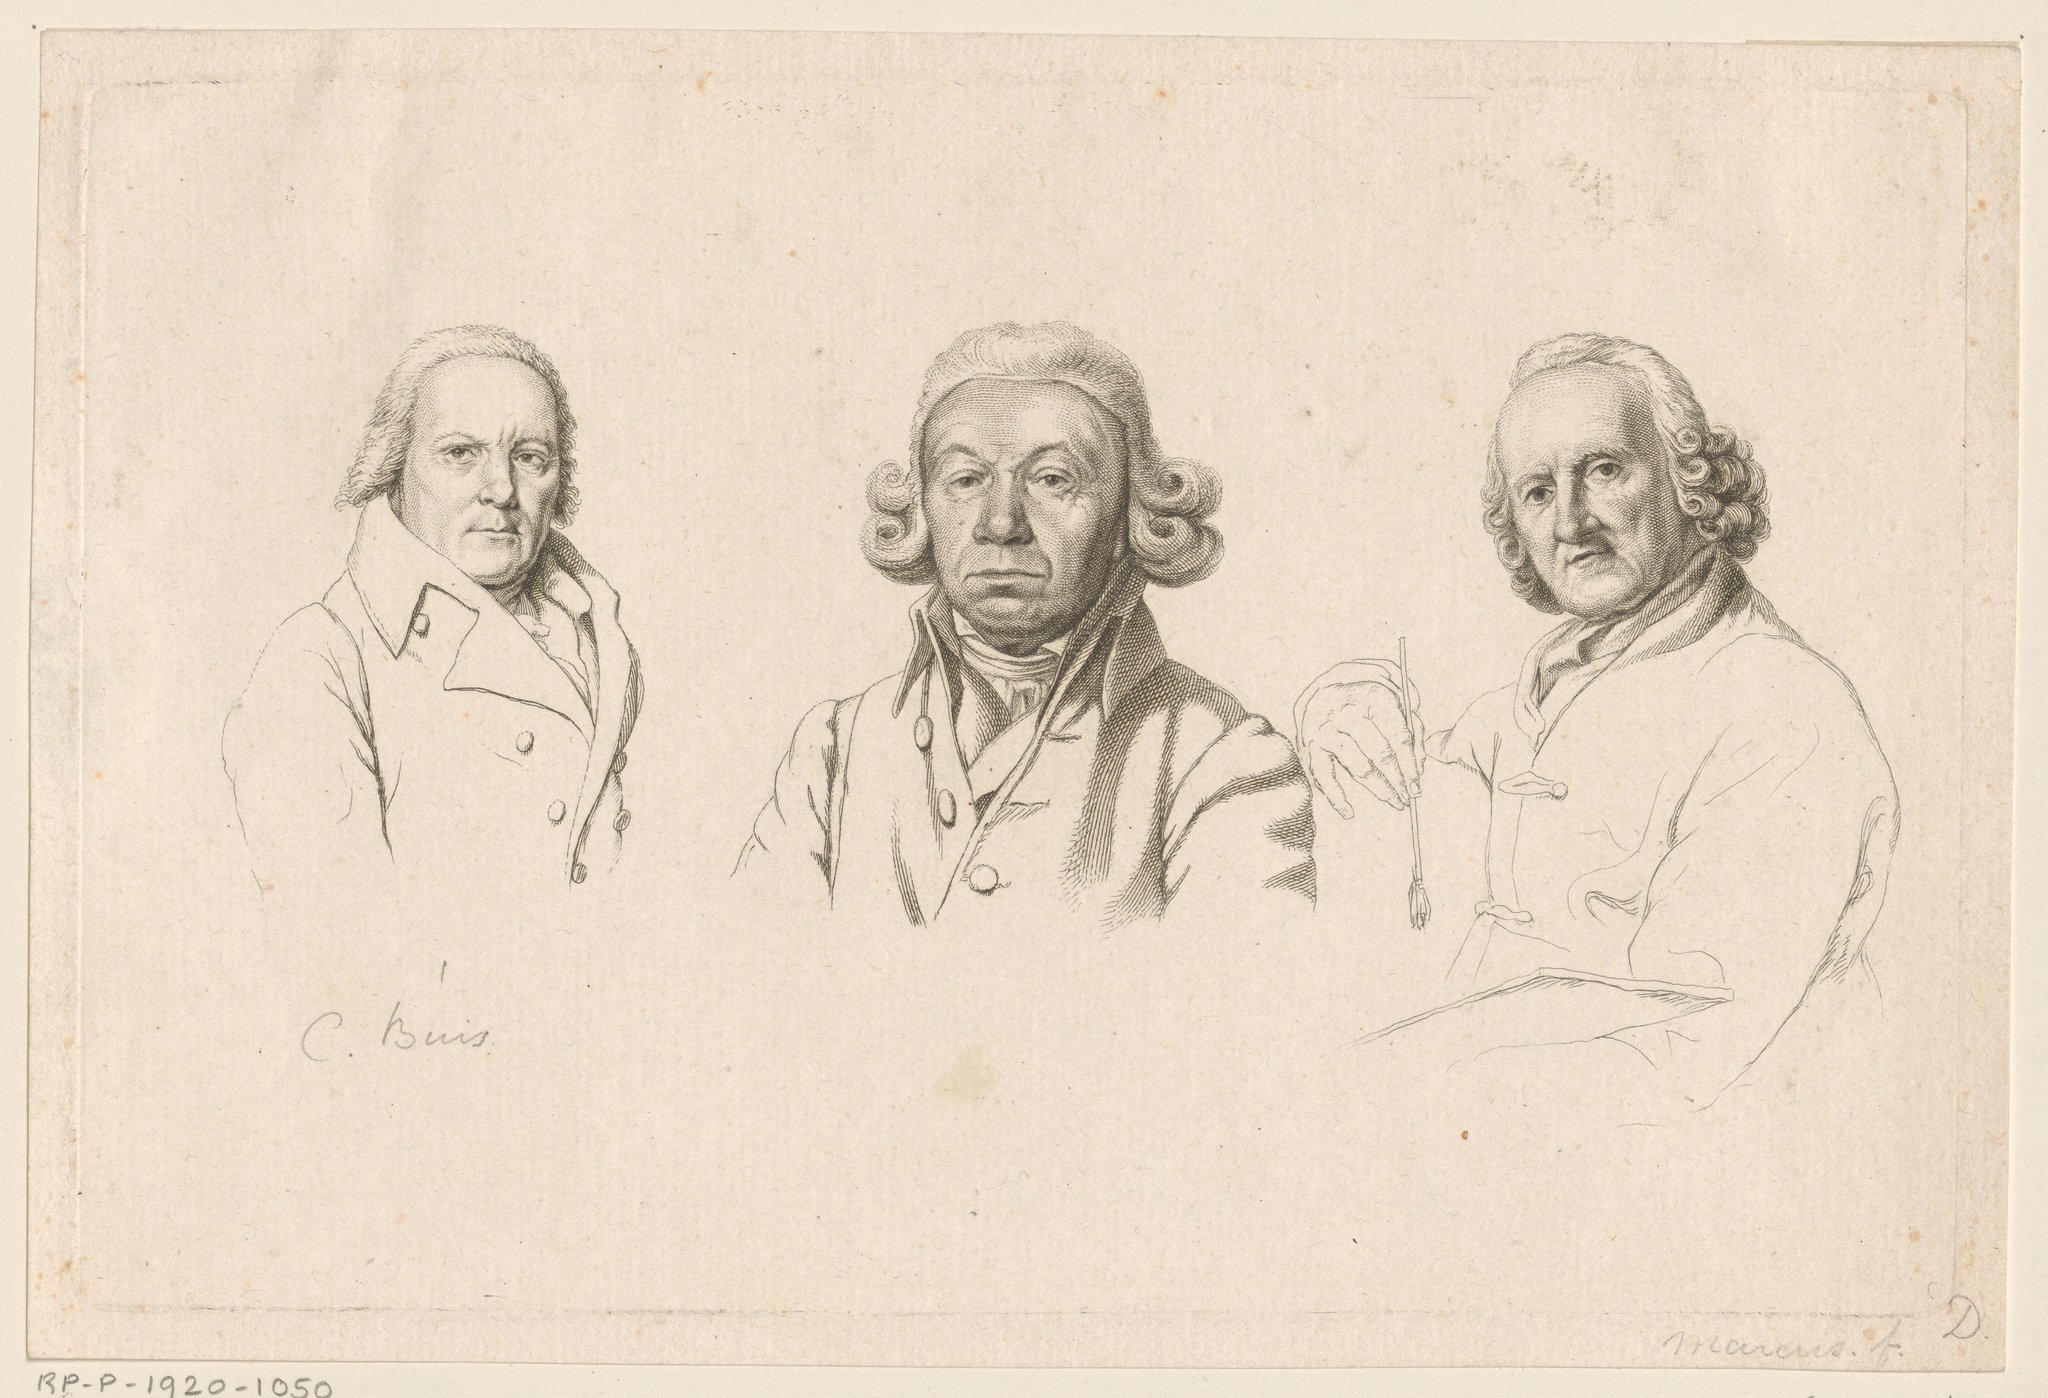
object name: print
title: Portretten van Jacobus Buys, Izaak Schmidt en Jurriaan Andriessen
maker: jacob ernst marcus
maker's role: draughtsman, print maker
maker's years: 1774-1826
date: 1812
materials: paper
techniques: etching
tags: amsterdam, painter, draughtsman, jurriaan andriessen, izaak schmidt, print maker, jacobus buys, drawing, historical persons, portrait, self-portrait of painter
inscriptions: collector's mark: Lugt 2228